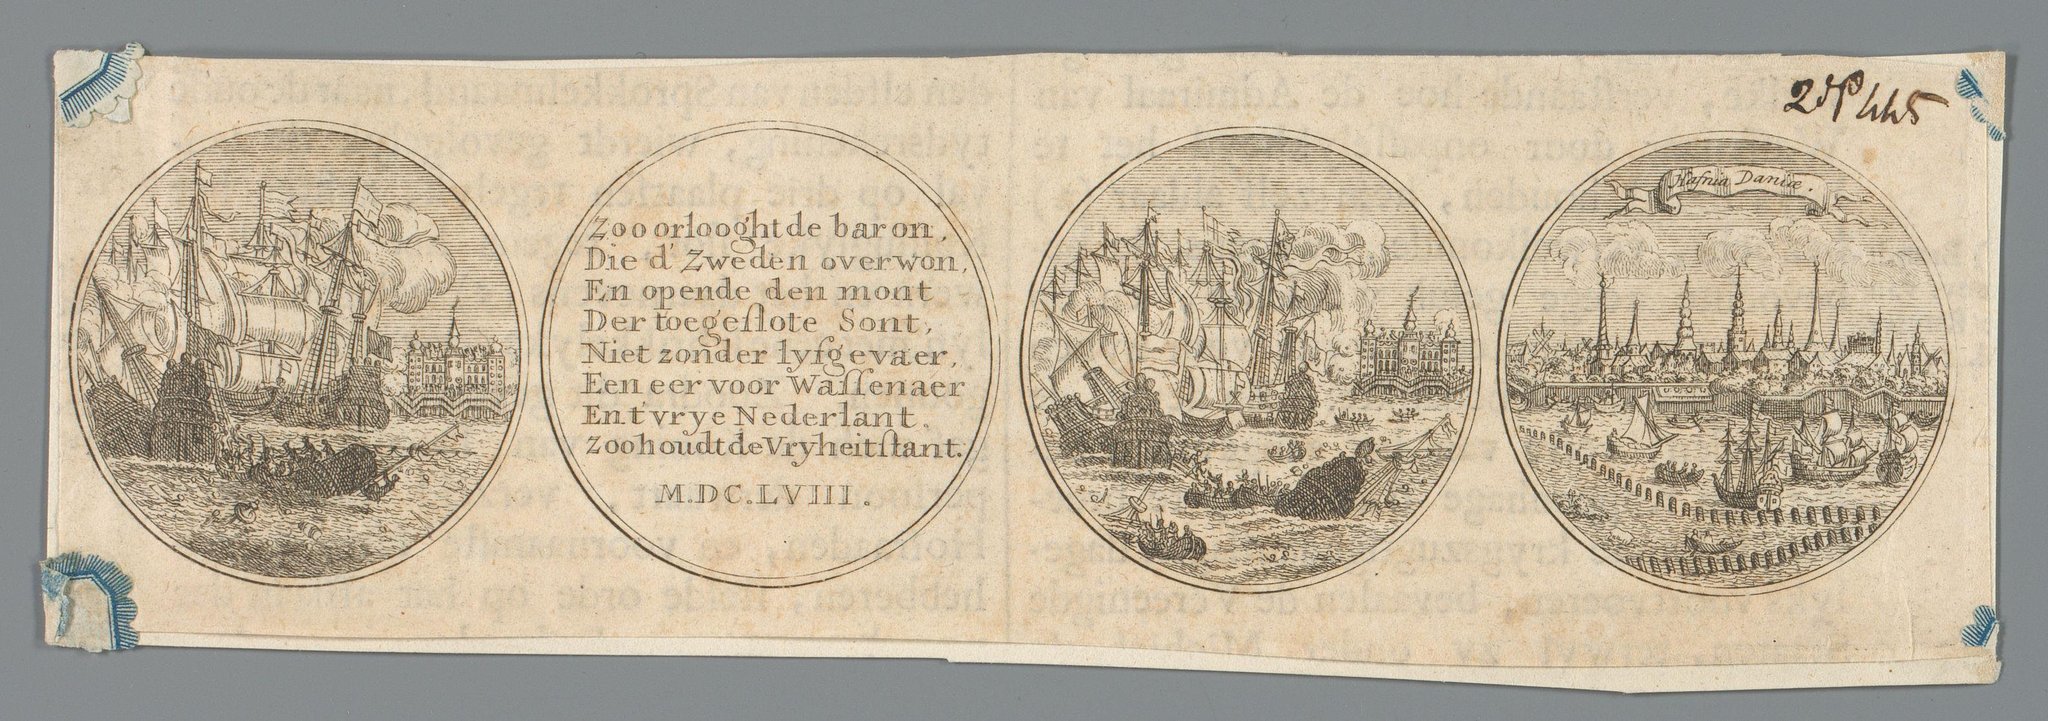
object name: print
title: Voor- en achterzijden van twee penningen met daarop een zeegevecht, een gedicht en het aanzicht van Kopenhagen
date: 1726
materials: paper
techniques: etching, letterpress printing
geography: the hague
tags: battle (+ naval force), coin, copenhagen (city)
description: Prent uit: Loon, Gerard van. Beschryving der Nederlandsche Historipenningen: (...). Den Haag: Christiaan van Lom et al., 1726, dl. 2, p. 445.